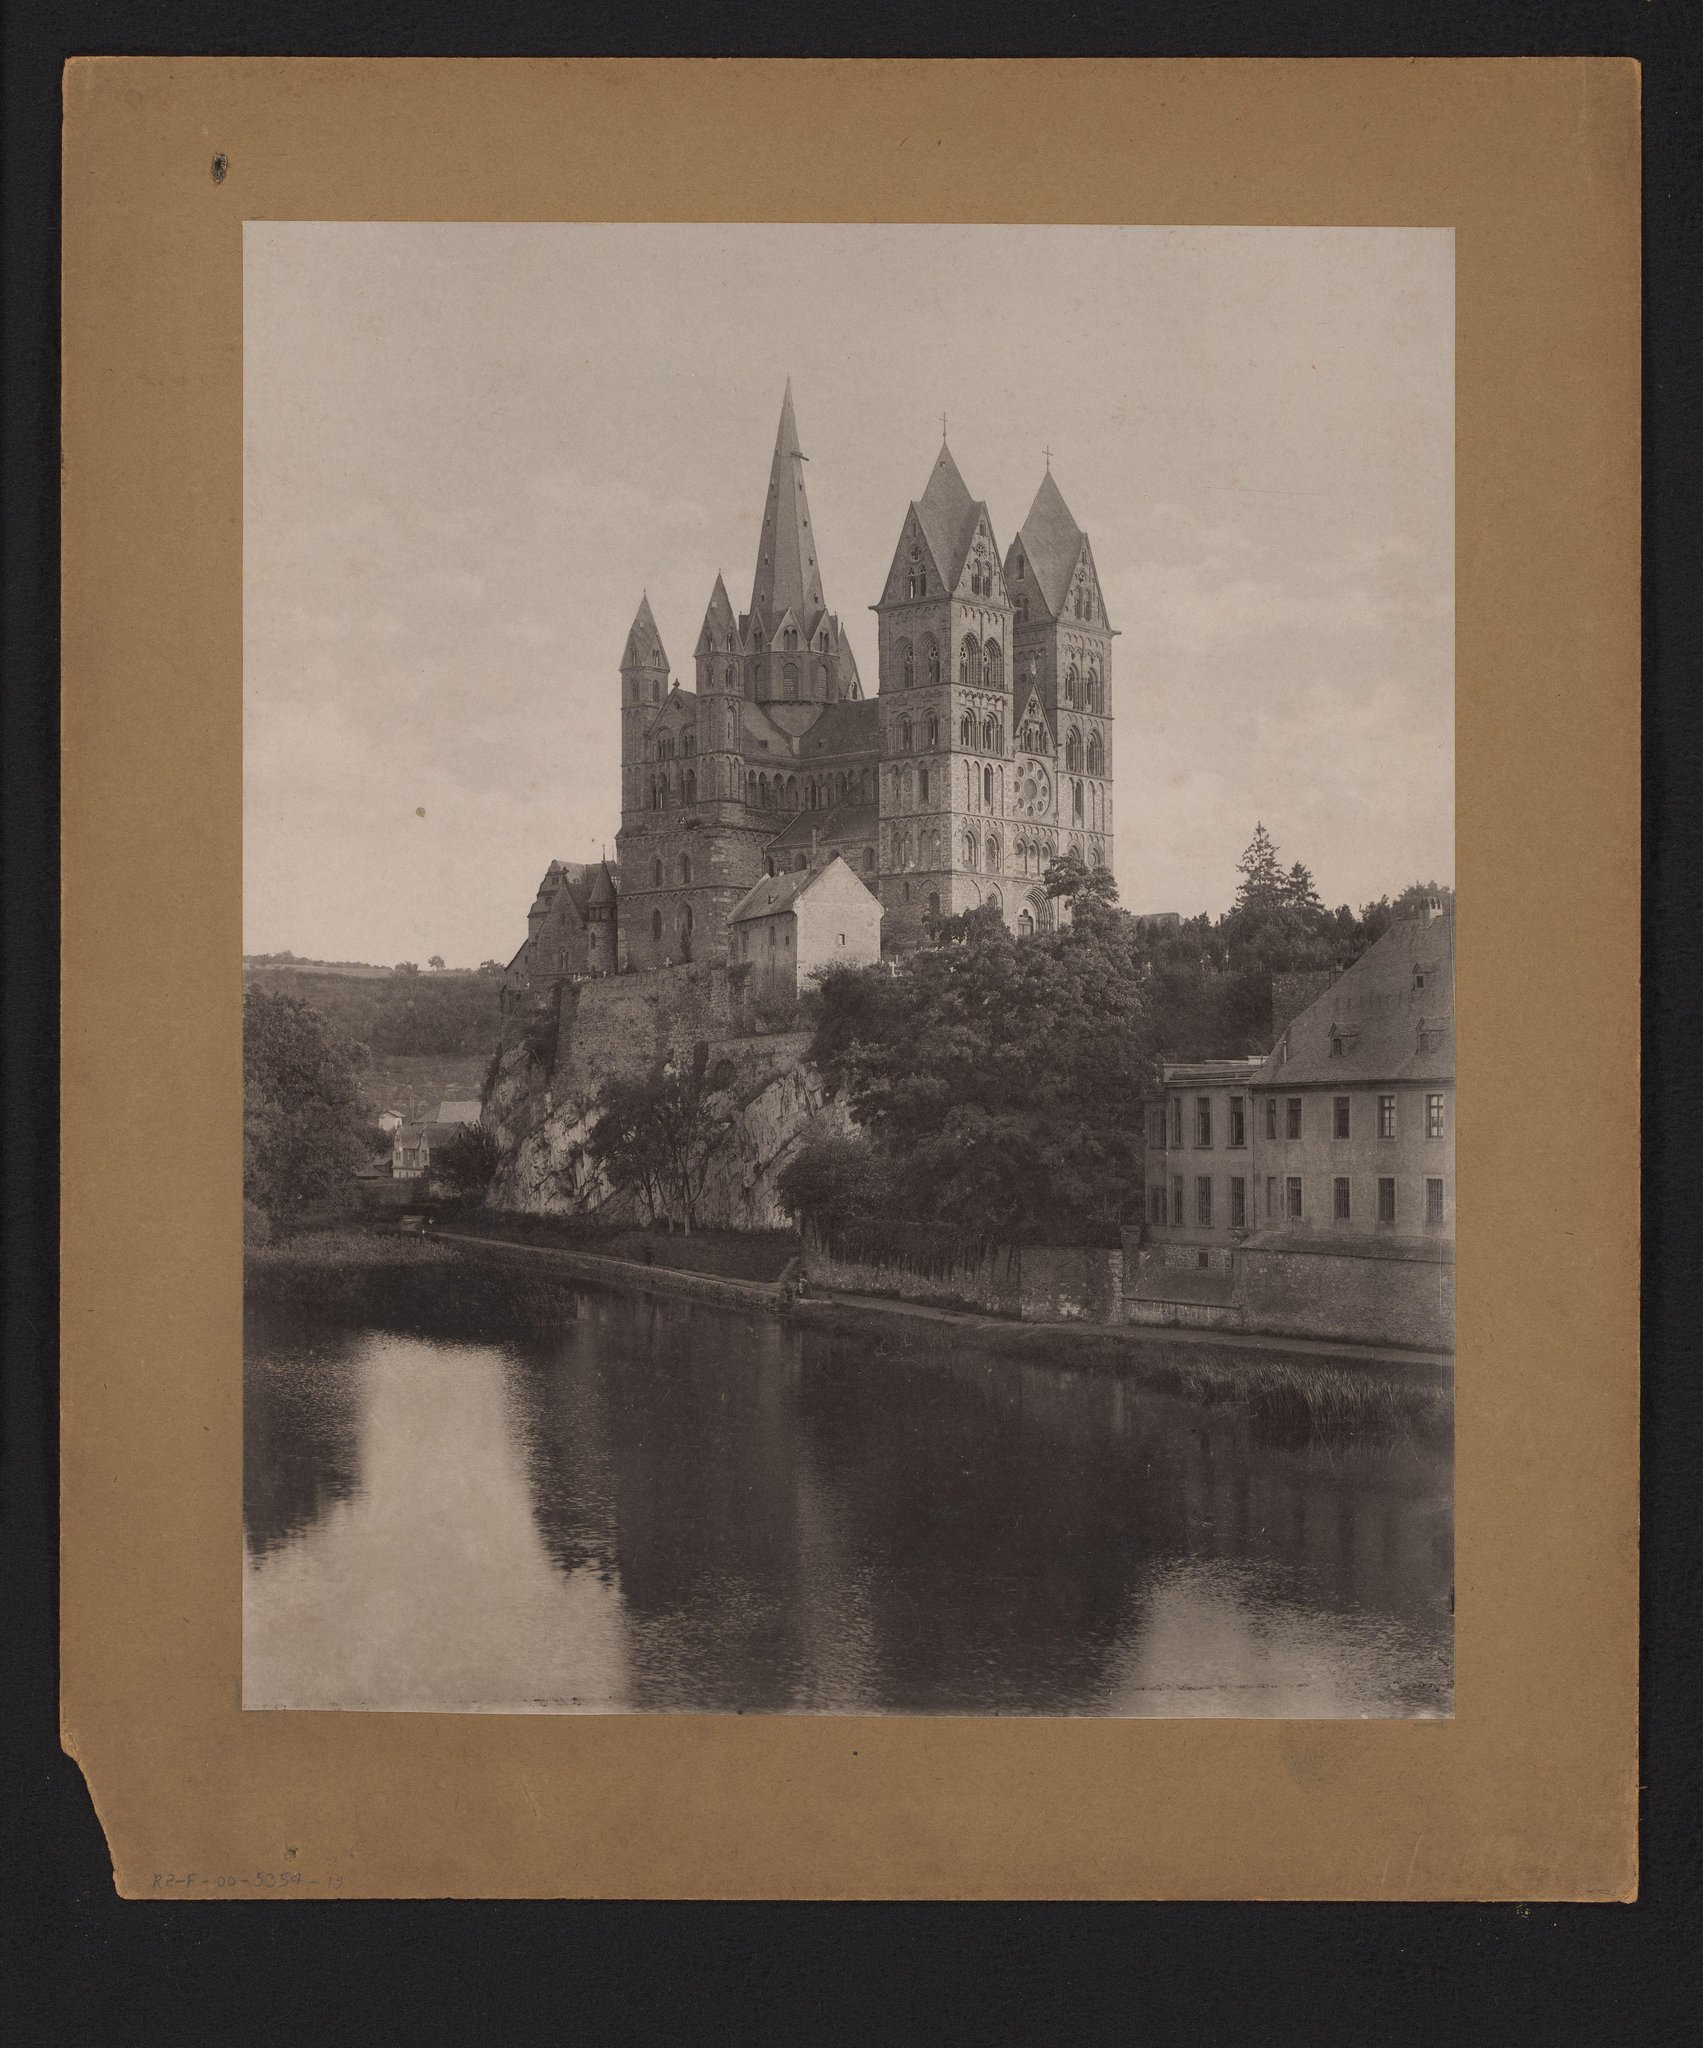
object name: photomechanical print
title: Gezicht op de Dom van Limburg an der Lahn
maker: Anonymous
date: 1890-1910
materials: cardboard, paper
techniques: photograph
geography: limburg an der lahn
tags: river, church (exterior)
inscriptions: inscription: ‘Limburg a/d Lahn’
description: Deze fotomechanische afdruk maakt deel uit van een omslag.